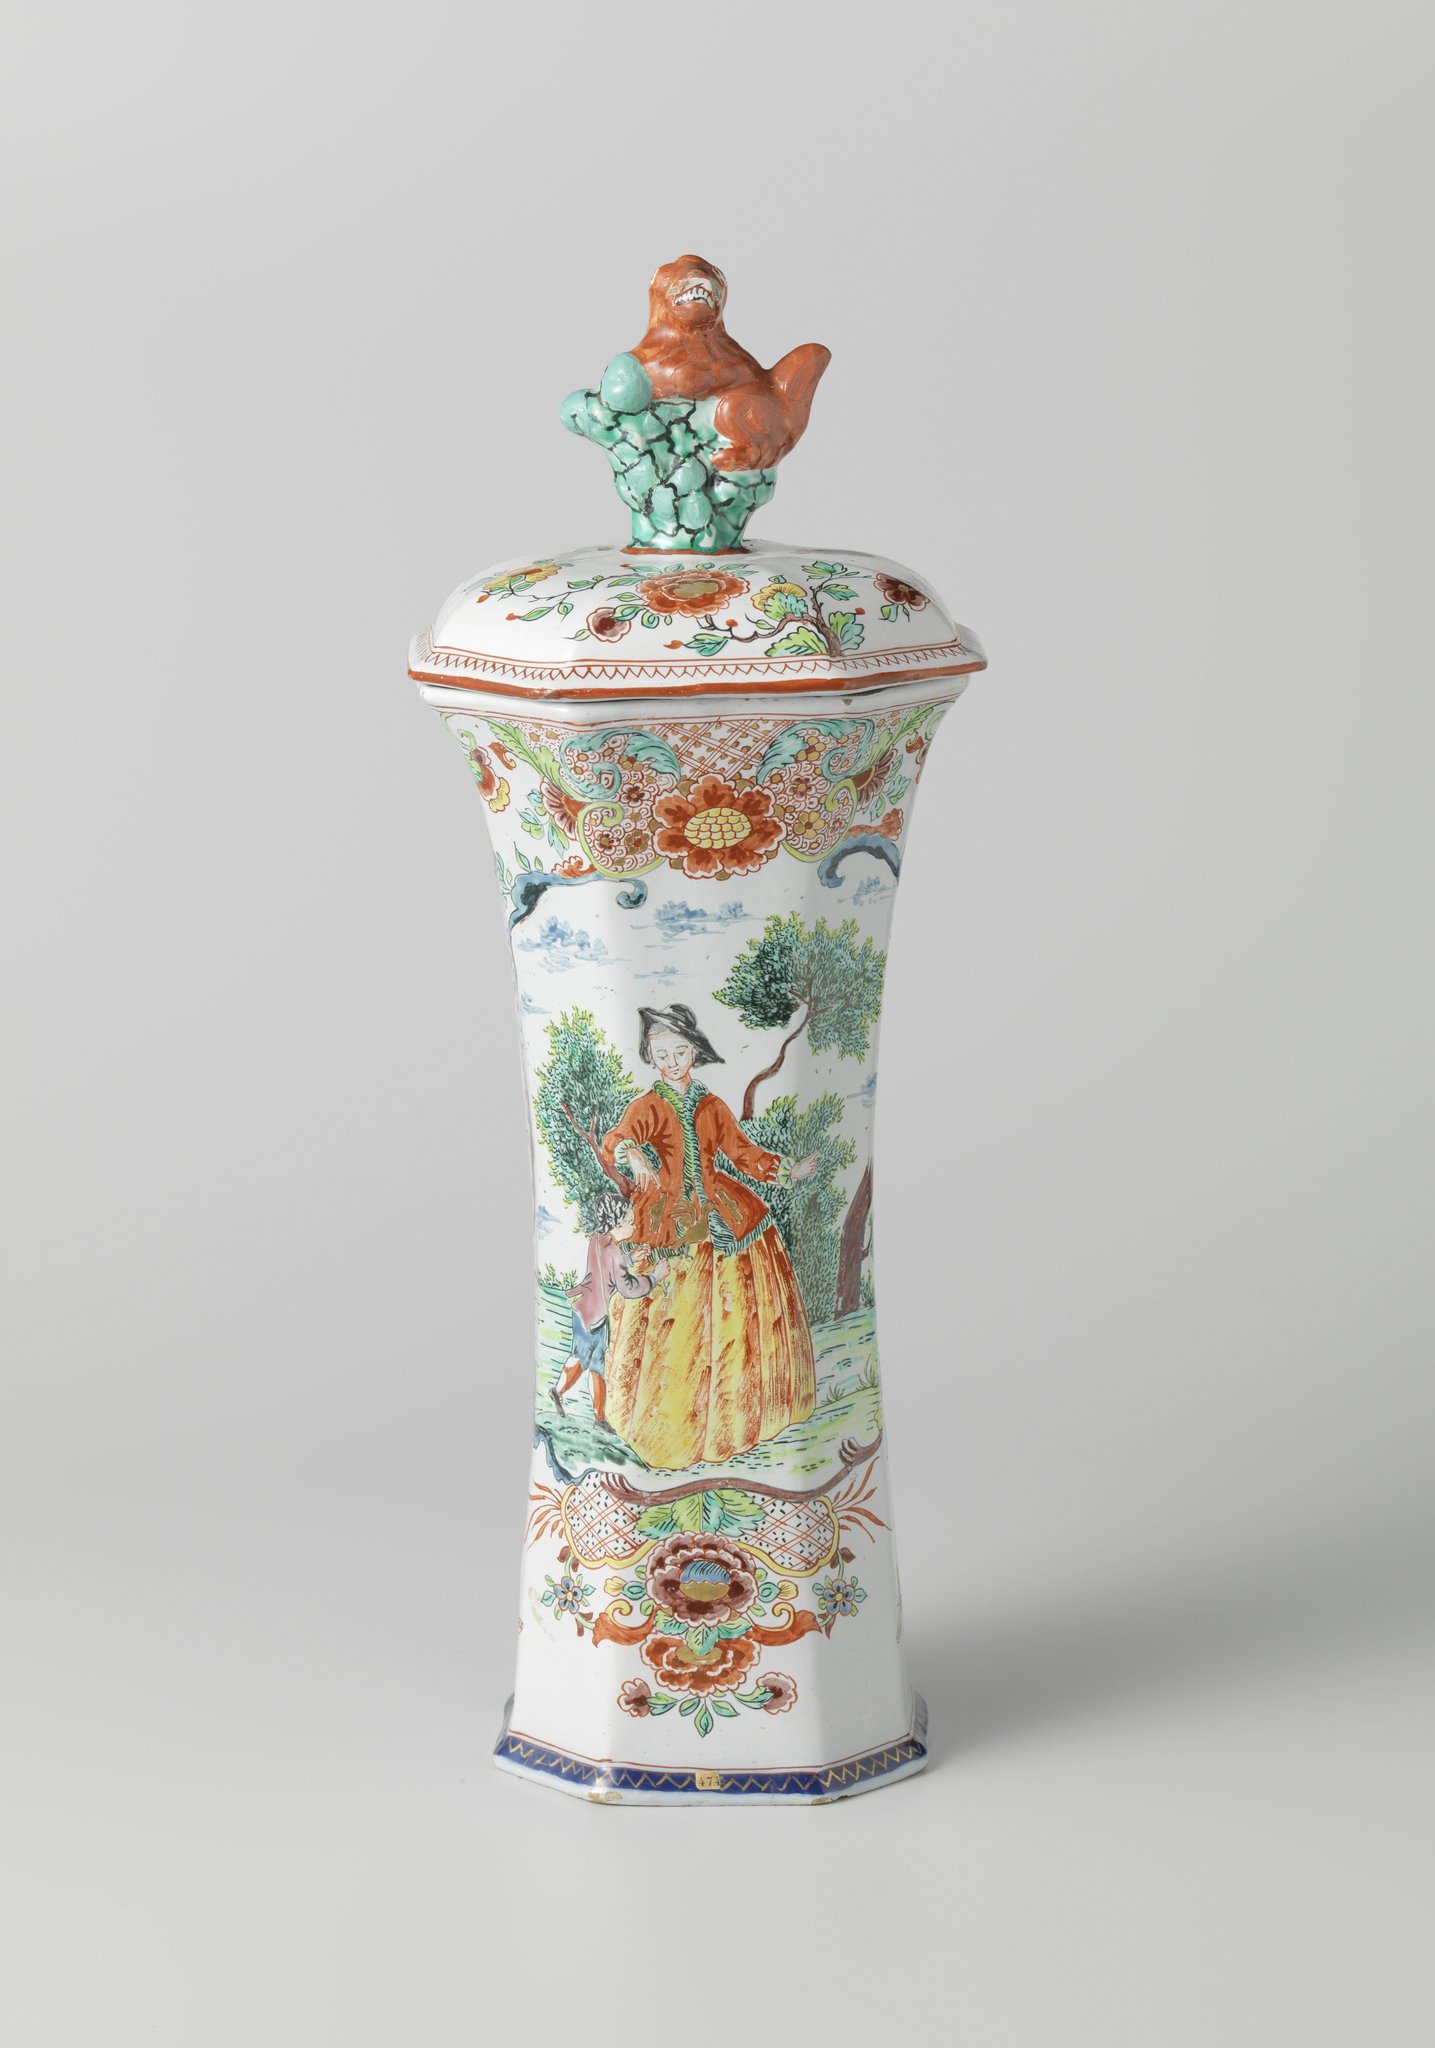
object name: kaststel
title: Deksel van een bekervaas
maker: Anonymous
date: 1740-1760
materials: faience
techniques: kiln, painted, polychromy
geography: delft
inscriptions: collector's mark: ‘collection J.F. Loudon’, inscription: ‘les 3 jun?’